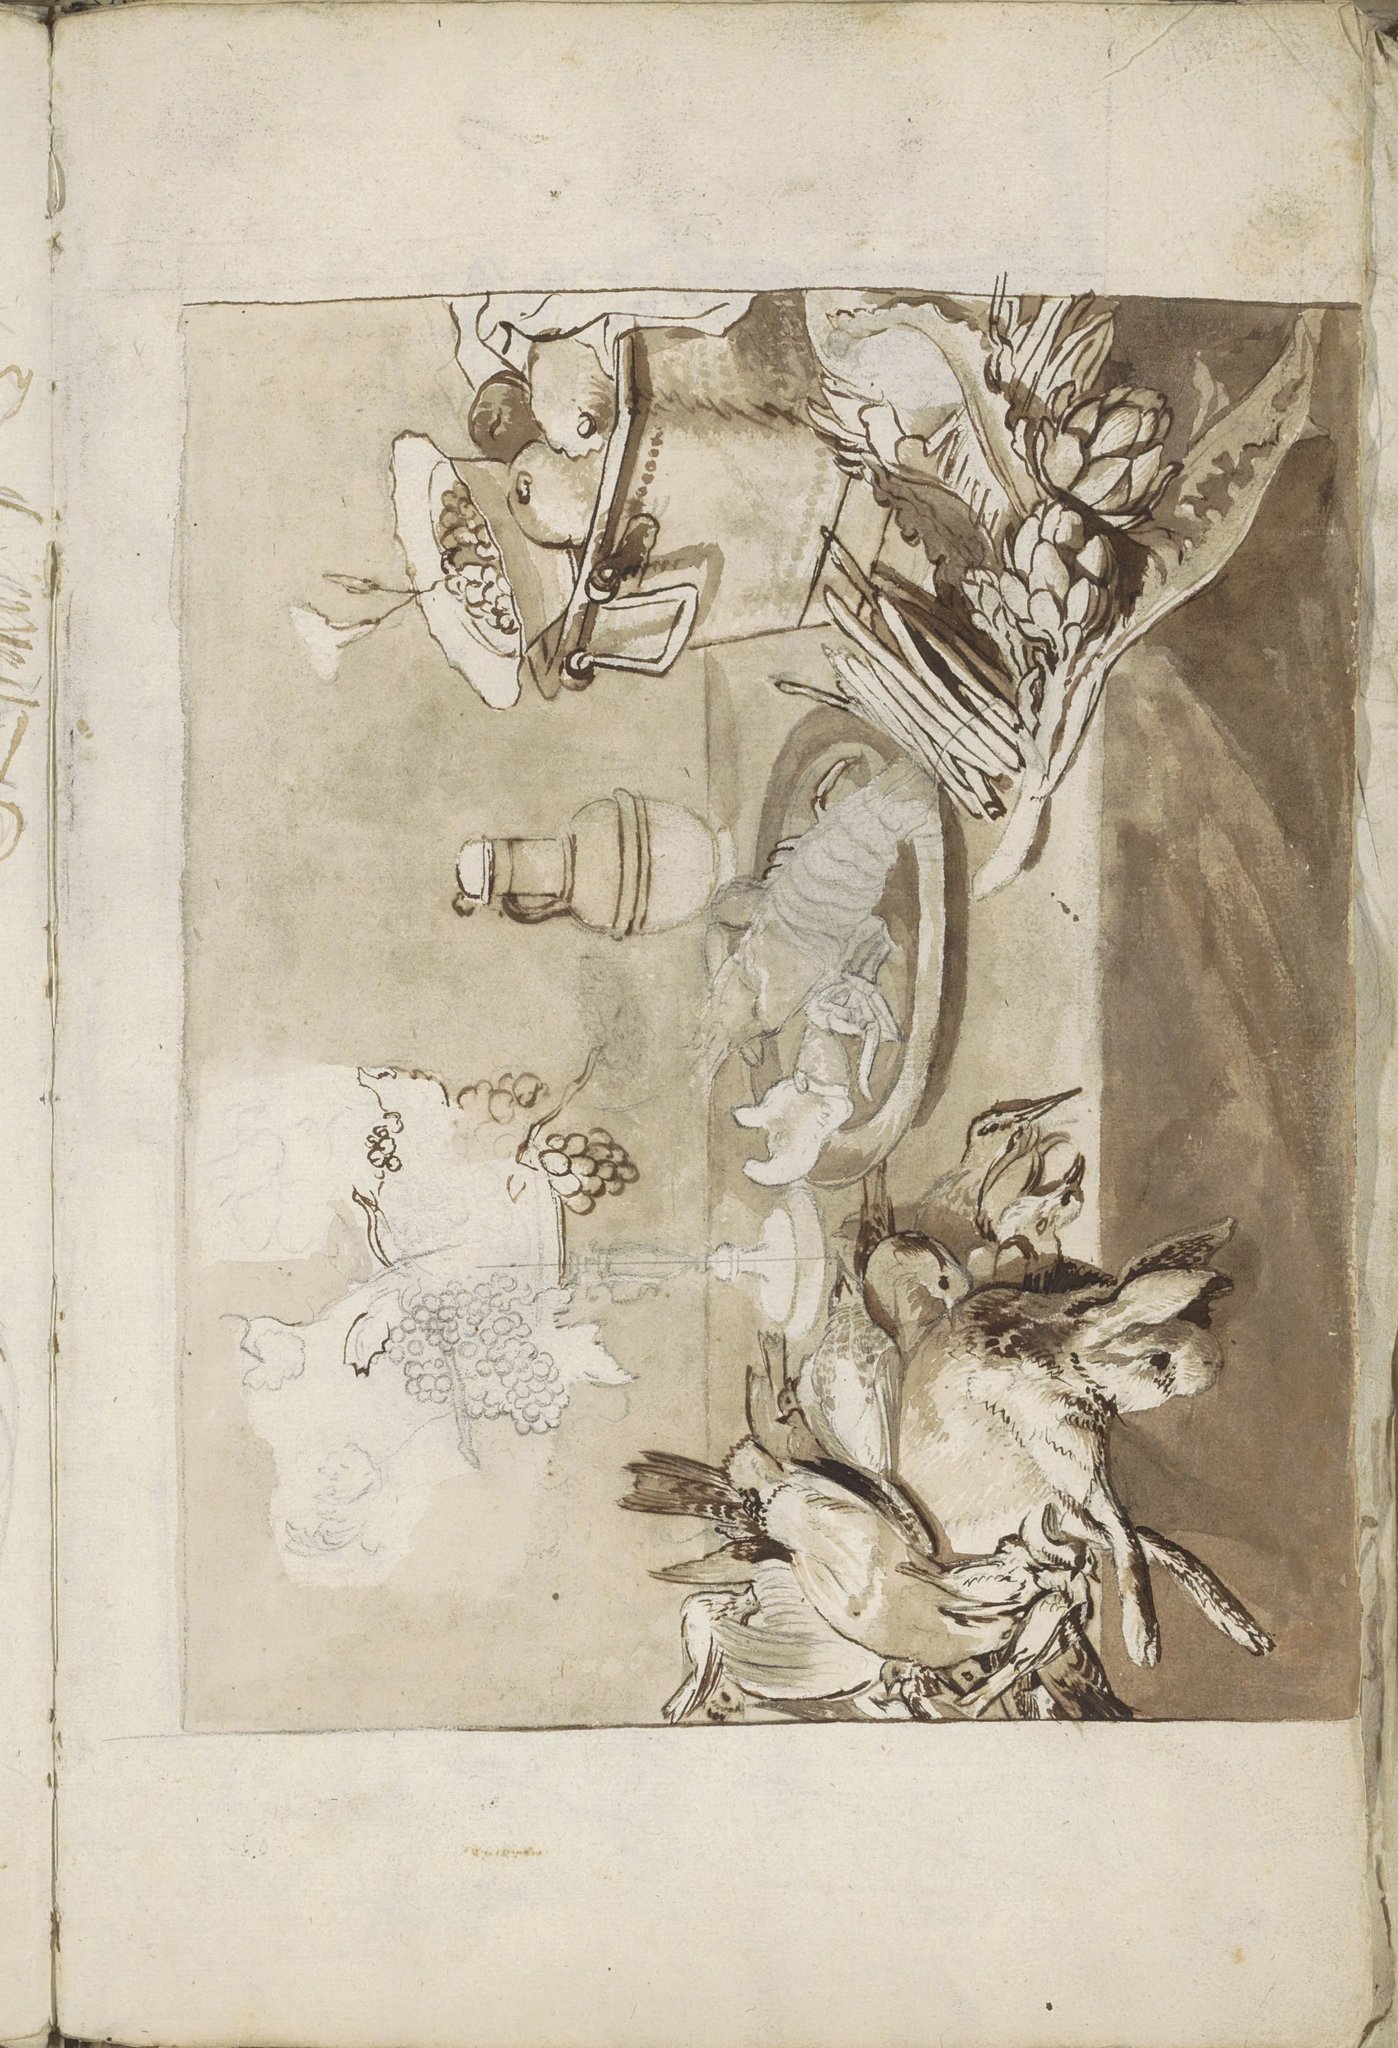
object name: sketchbook leaf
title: Stilleven met wild, gevogelte, artisjokken en krab op een tafel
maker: paul de vos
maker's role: draughtsman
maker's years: 1595-1678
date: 1605-1678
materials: ink, paper, pencil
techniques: brush, pen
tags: still life of related objects, fowl (cock, hen, chicken, etc.), crustaceans: lobster, fruits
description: Tekening in een kader. Blad 5 recto uit een schetsboek met 15 bladen.